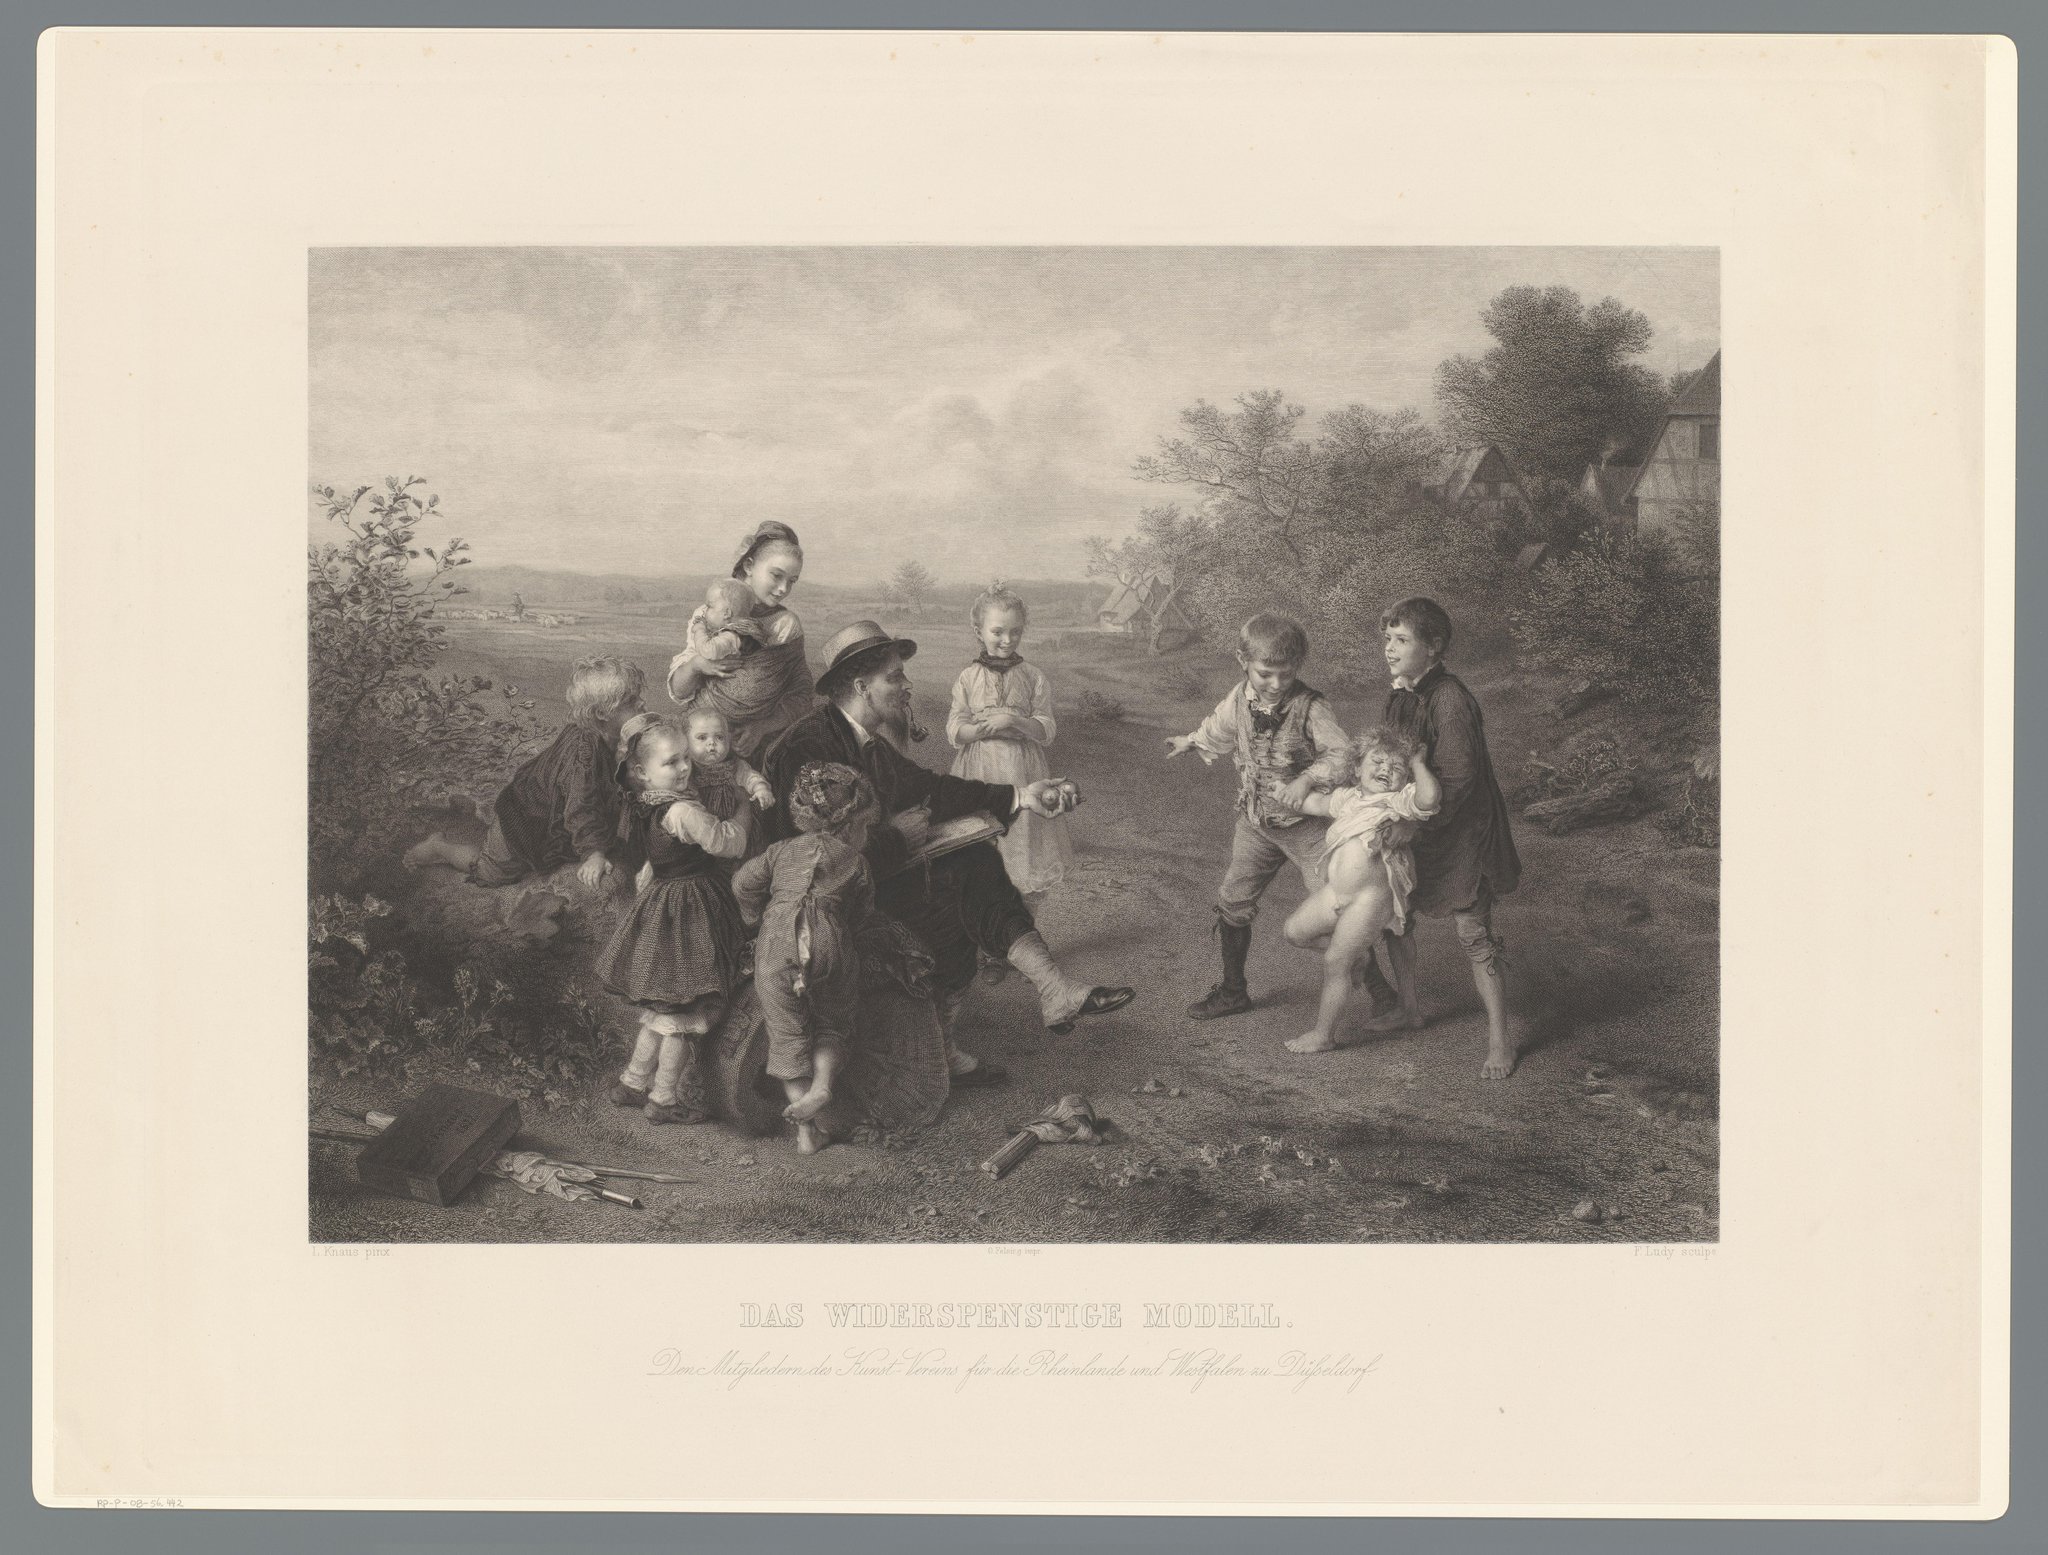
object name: print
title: Kunstenaar omringd door kinderen en tegenspartelend model in een veld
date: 1877-1920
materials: paper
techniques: etching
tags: artist (in general) (+ model, sitter), artist's model, sitter - bb - out of doors, artist (in general) (+ artist at work with assistants or pupils)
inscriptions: collector's mark: Lugt 2228